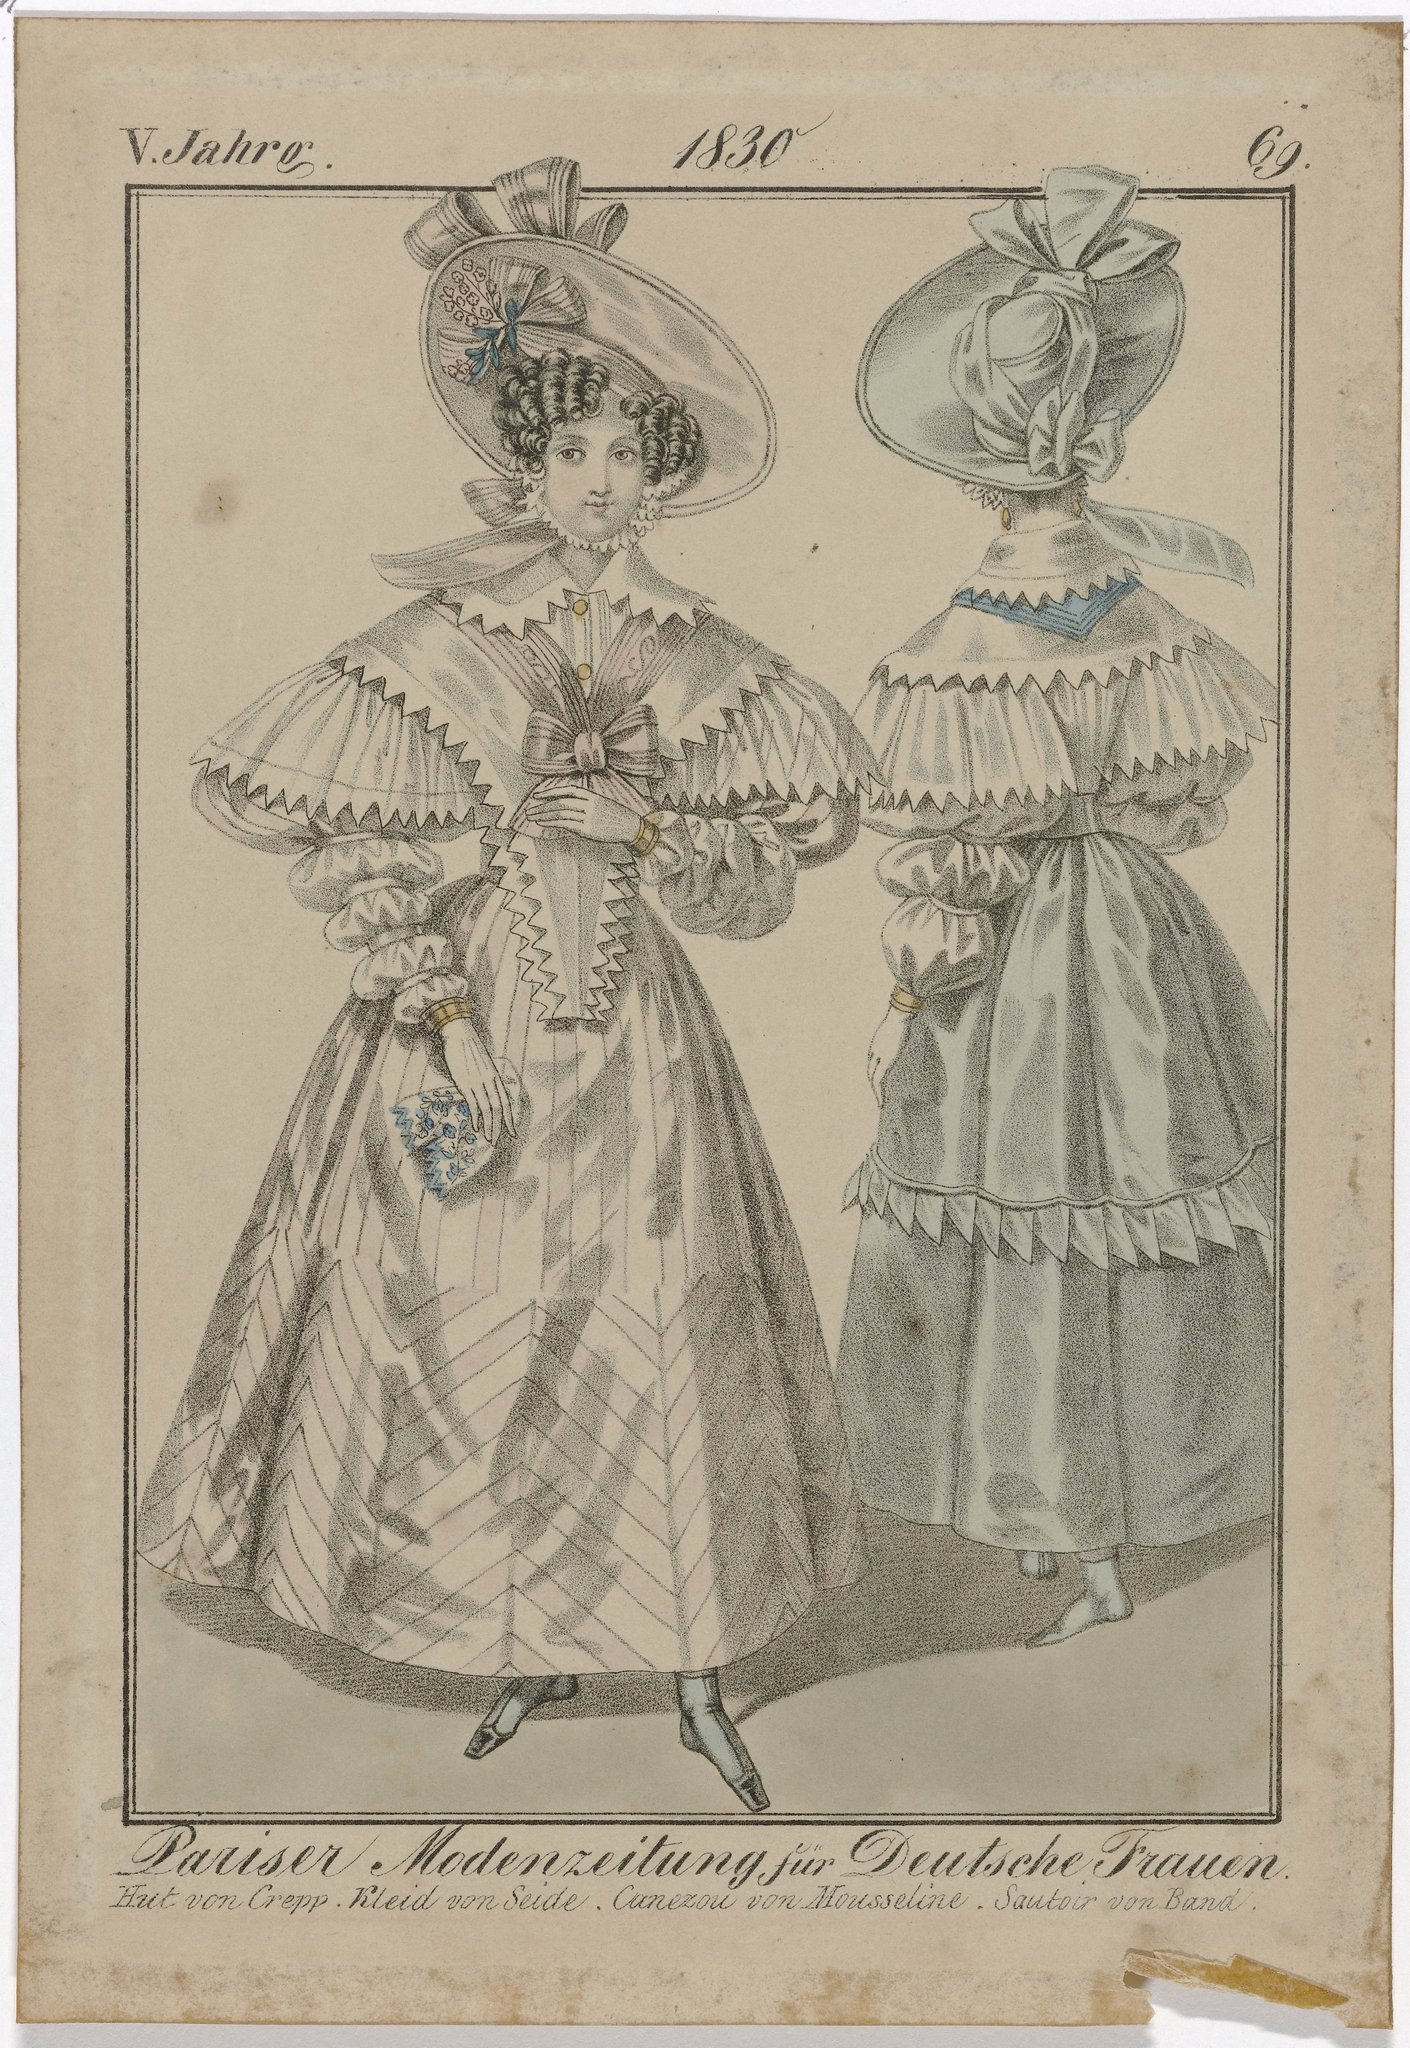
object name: fashion print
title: Pariser Modenzeitung für Deutsche Frauen, 1830 V. Jahrg (69) : Hut von Crepp (...)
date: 1830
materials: paper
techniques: hand coloring, lithograph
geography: aachen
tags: handkerchief (+ women's clothes), fashion plates, head-gear: hat (+ women's clothes), gloves, mittens, etc. (+ women's clothes), dress, gown (+ women's clothes), bracelet, wristlet (+ women's clothes)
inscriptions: caption: ‘Hut von Crepp. kleid von Seide. Canezou von Mousseline. Sautoir von Band.’, title: ‘Pariser Modenzeitung für Deutsche Frauen’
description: Vrouw in een japon van zijde en 'canezou' van mousseline. Accessoires: sautoir van band, hoed van crêpe, zakdoek met bloemmotief, enkellaarzen.